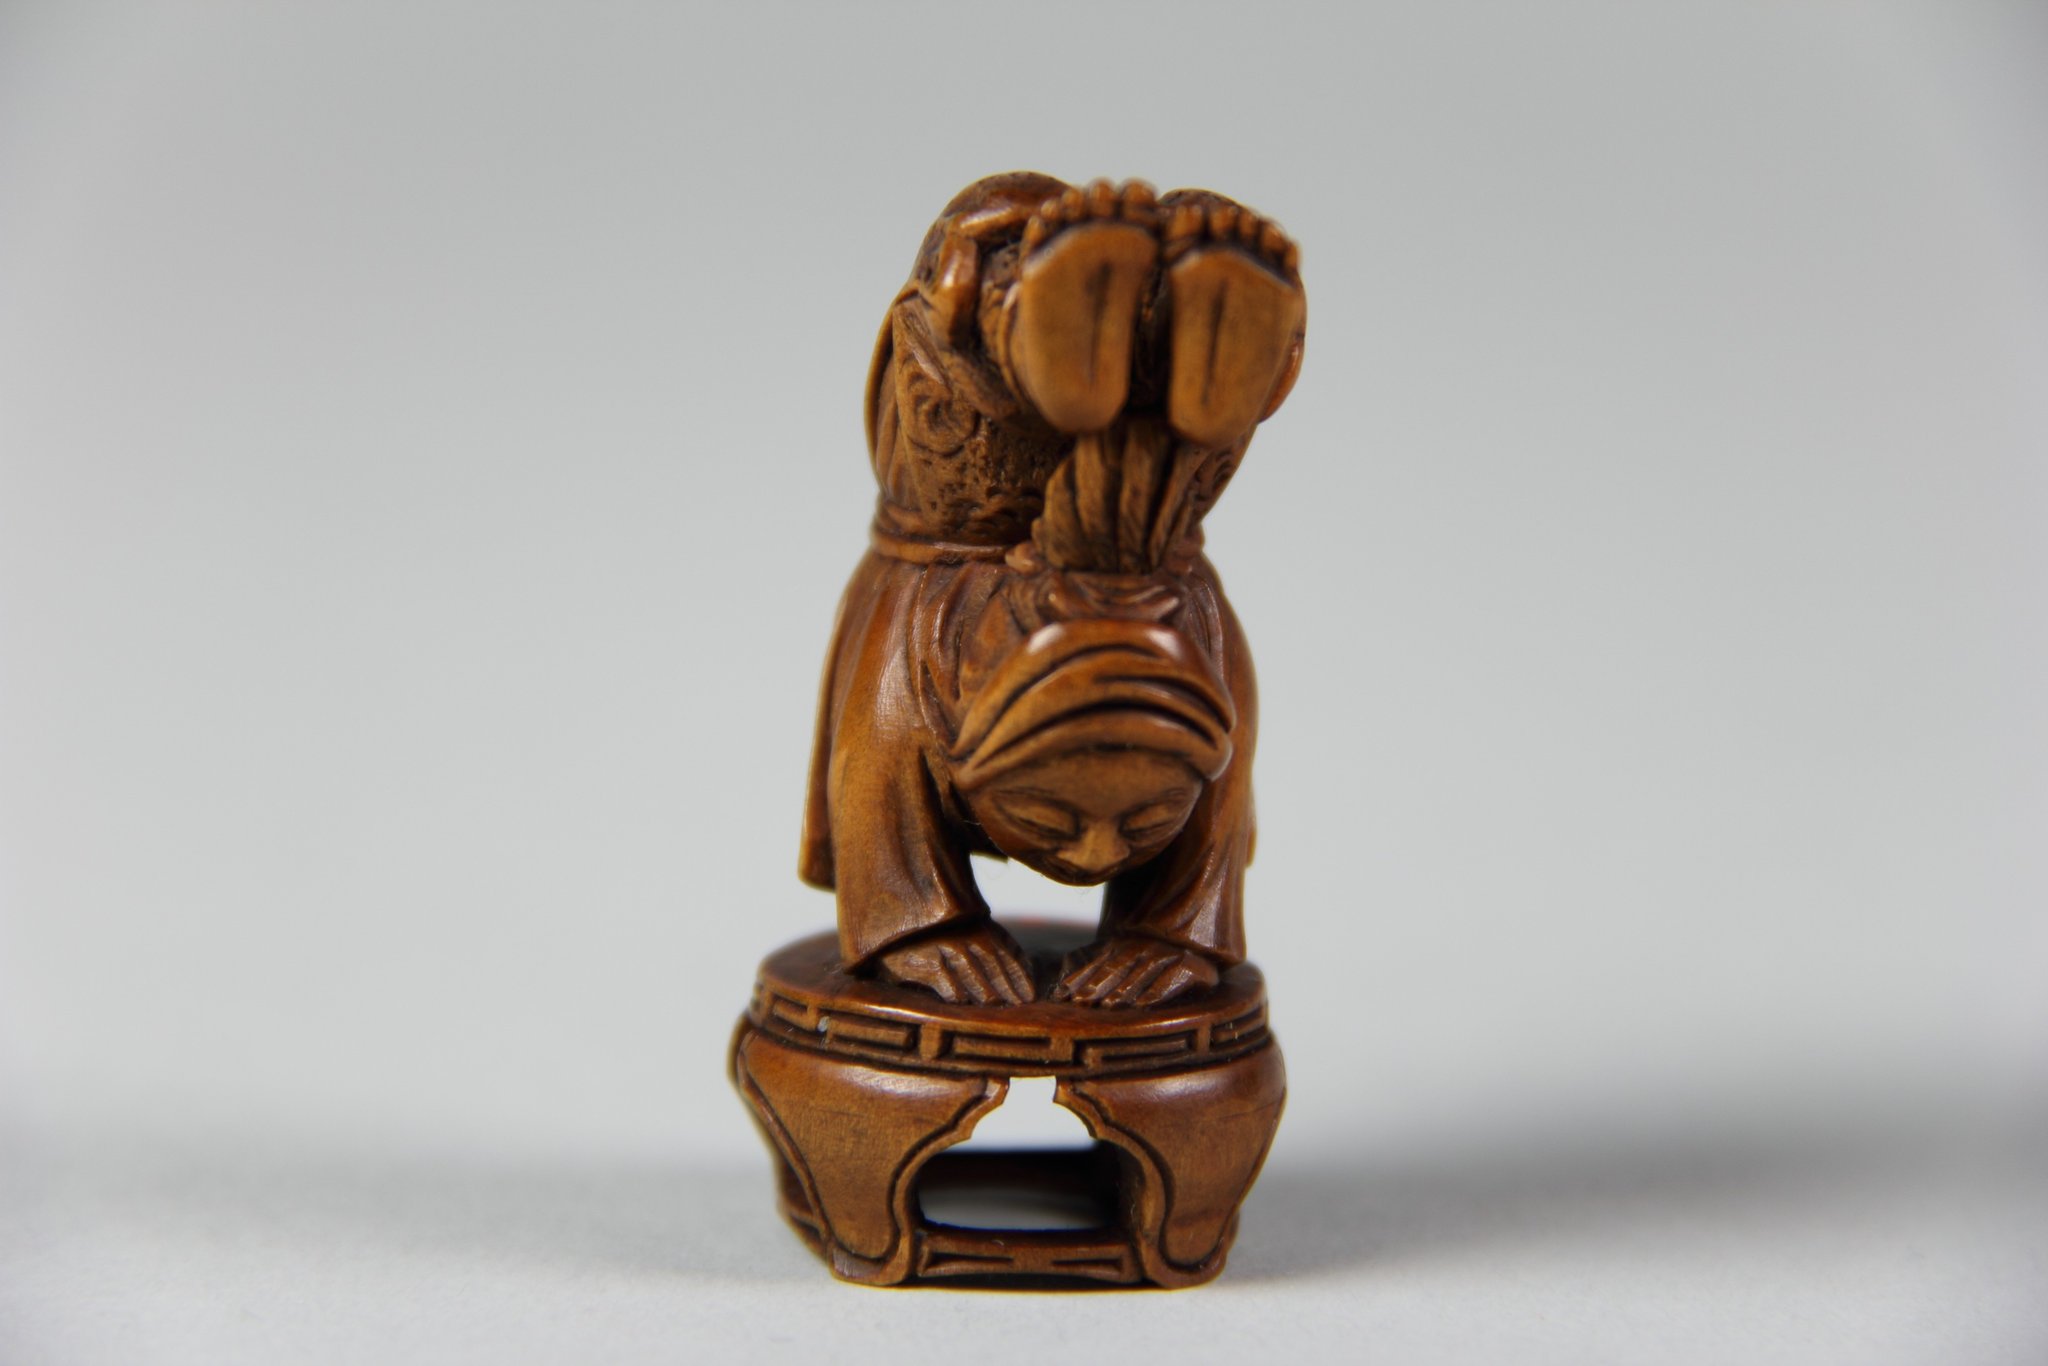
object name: netsuke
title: Netsuke of Acrobat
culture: japanese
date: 1801-1900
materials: wood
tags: human figures,acrobats